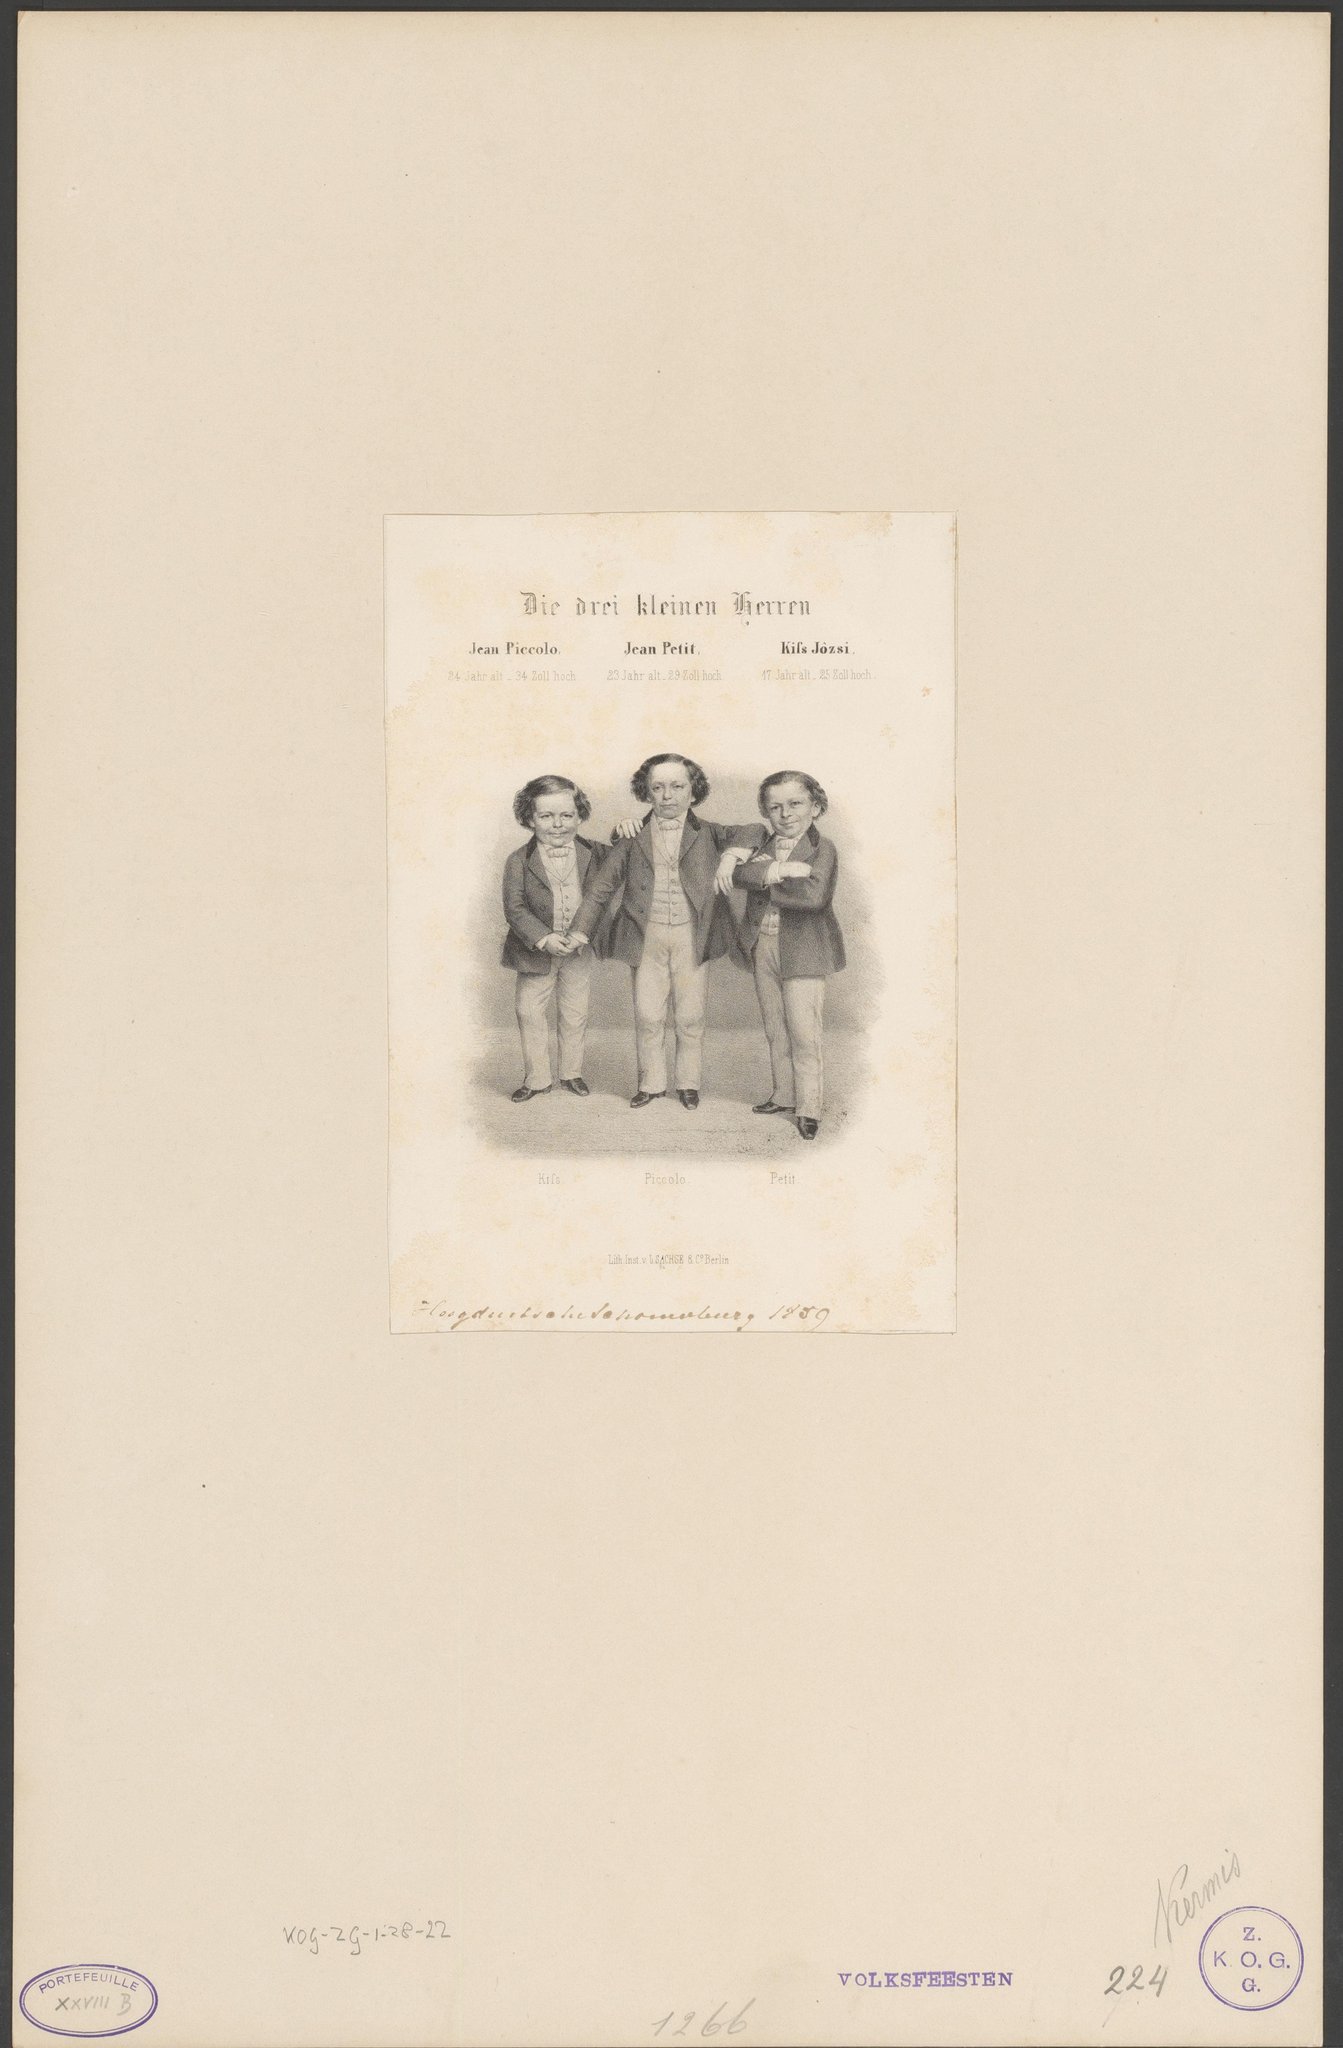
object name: print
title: Die drei kleinen Herren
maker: Anonymous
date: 1832-1881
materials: paper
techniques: lithograph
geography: berlin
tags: little people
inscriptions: collector's mark: Lugt 1641, stamp, stamp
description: Drie kleine mannen naast elkaar. Boven de voorstelling de namen, leeftijd en afmeting van de heren. Onderwerpsrubrieken binnen de Atlas Zeden en Gewoonten: Zeden en Gewoonten in Engeren Zin. Volksleven. Volksfeesten. Kermistypen, wondermenschen en dergelijken.